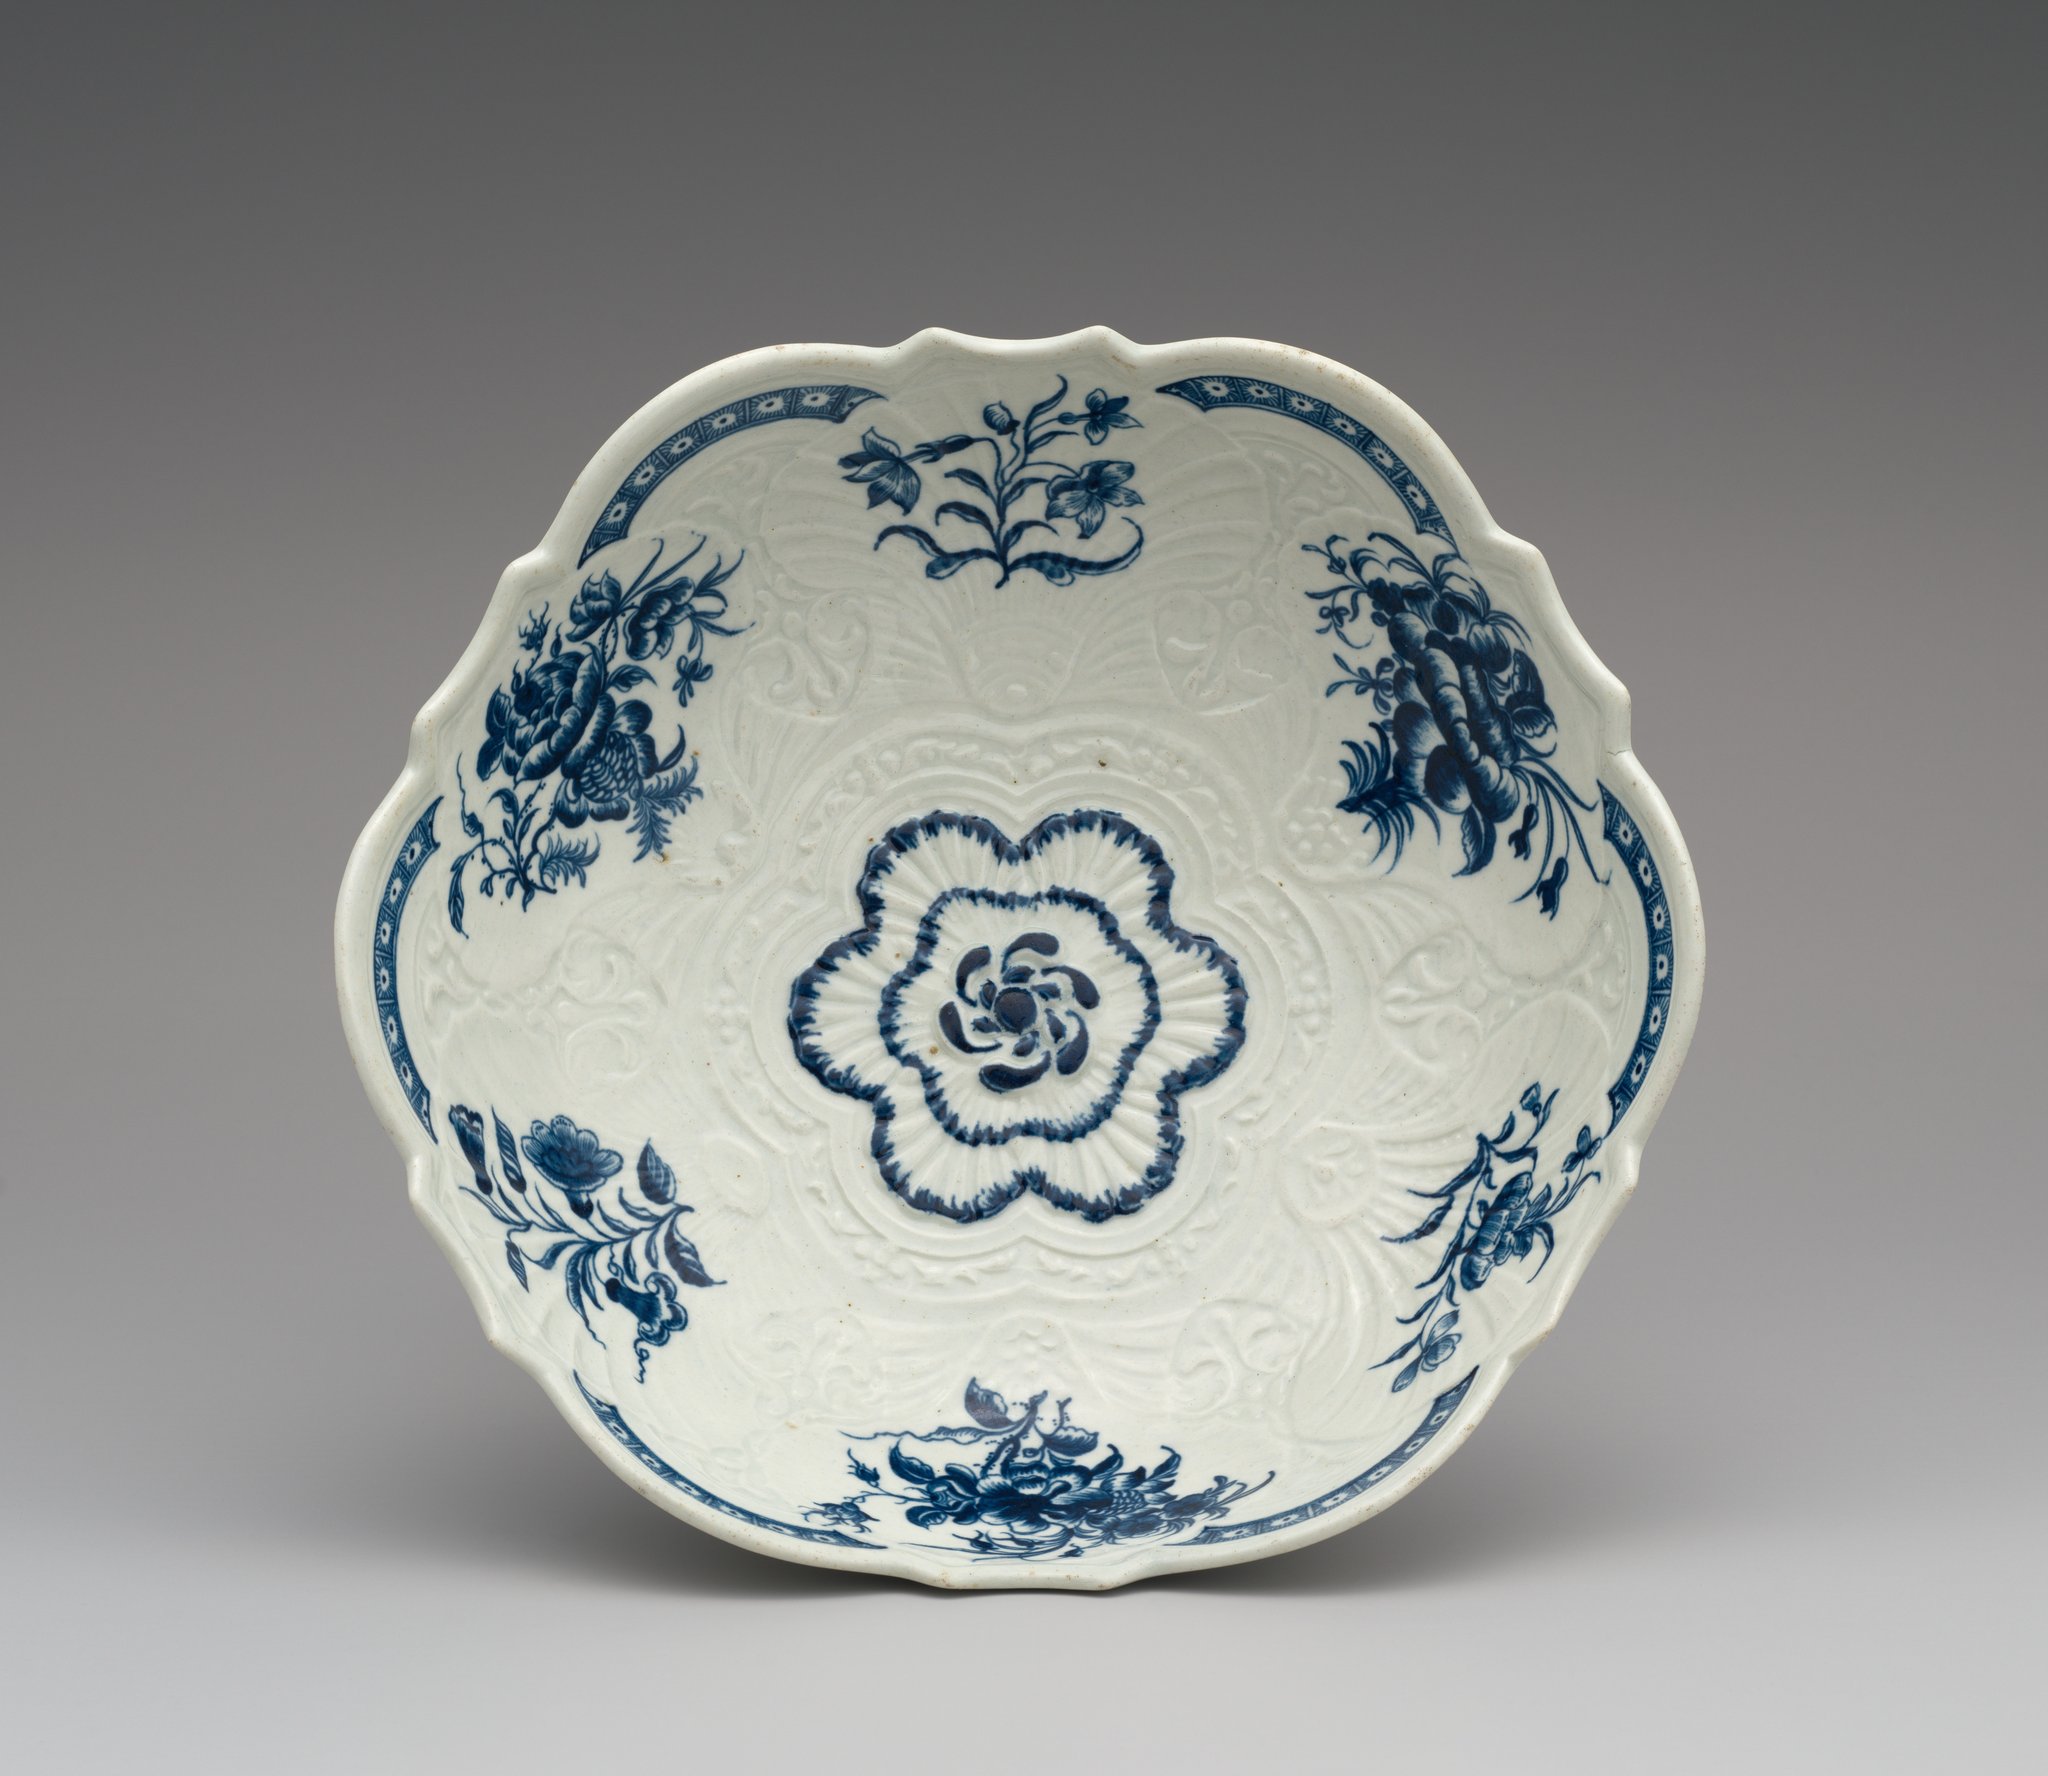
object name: bowl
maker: worcester factory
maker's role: factory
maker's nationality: british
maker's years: 1751-2008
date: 1770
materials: soft paste porcelain